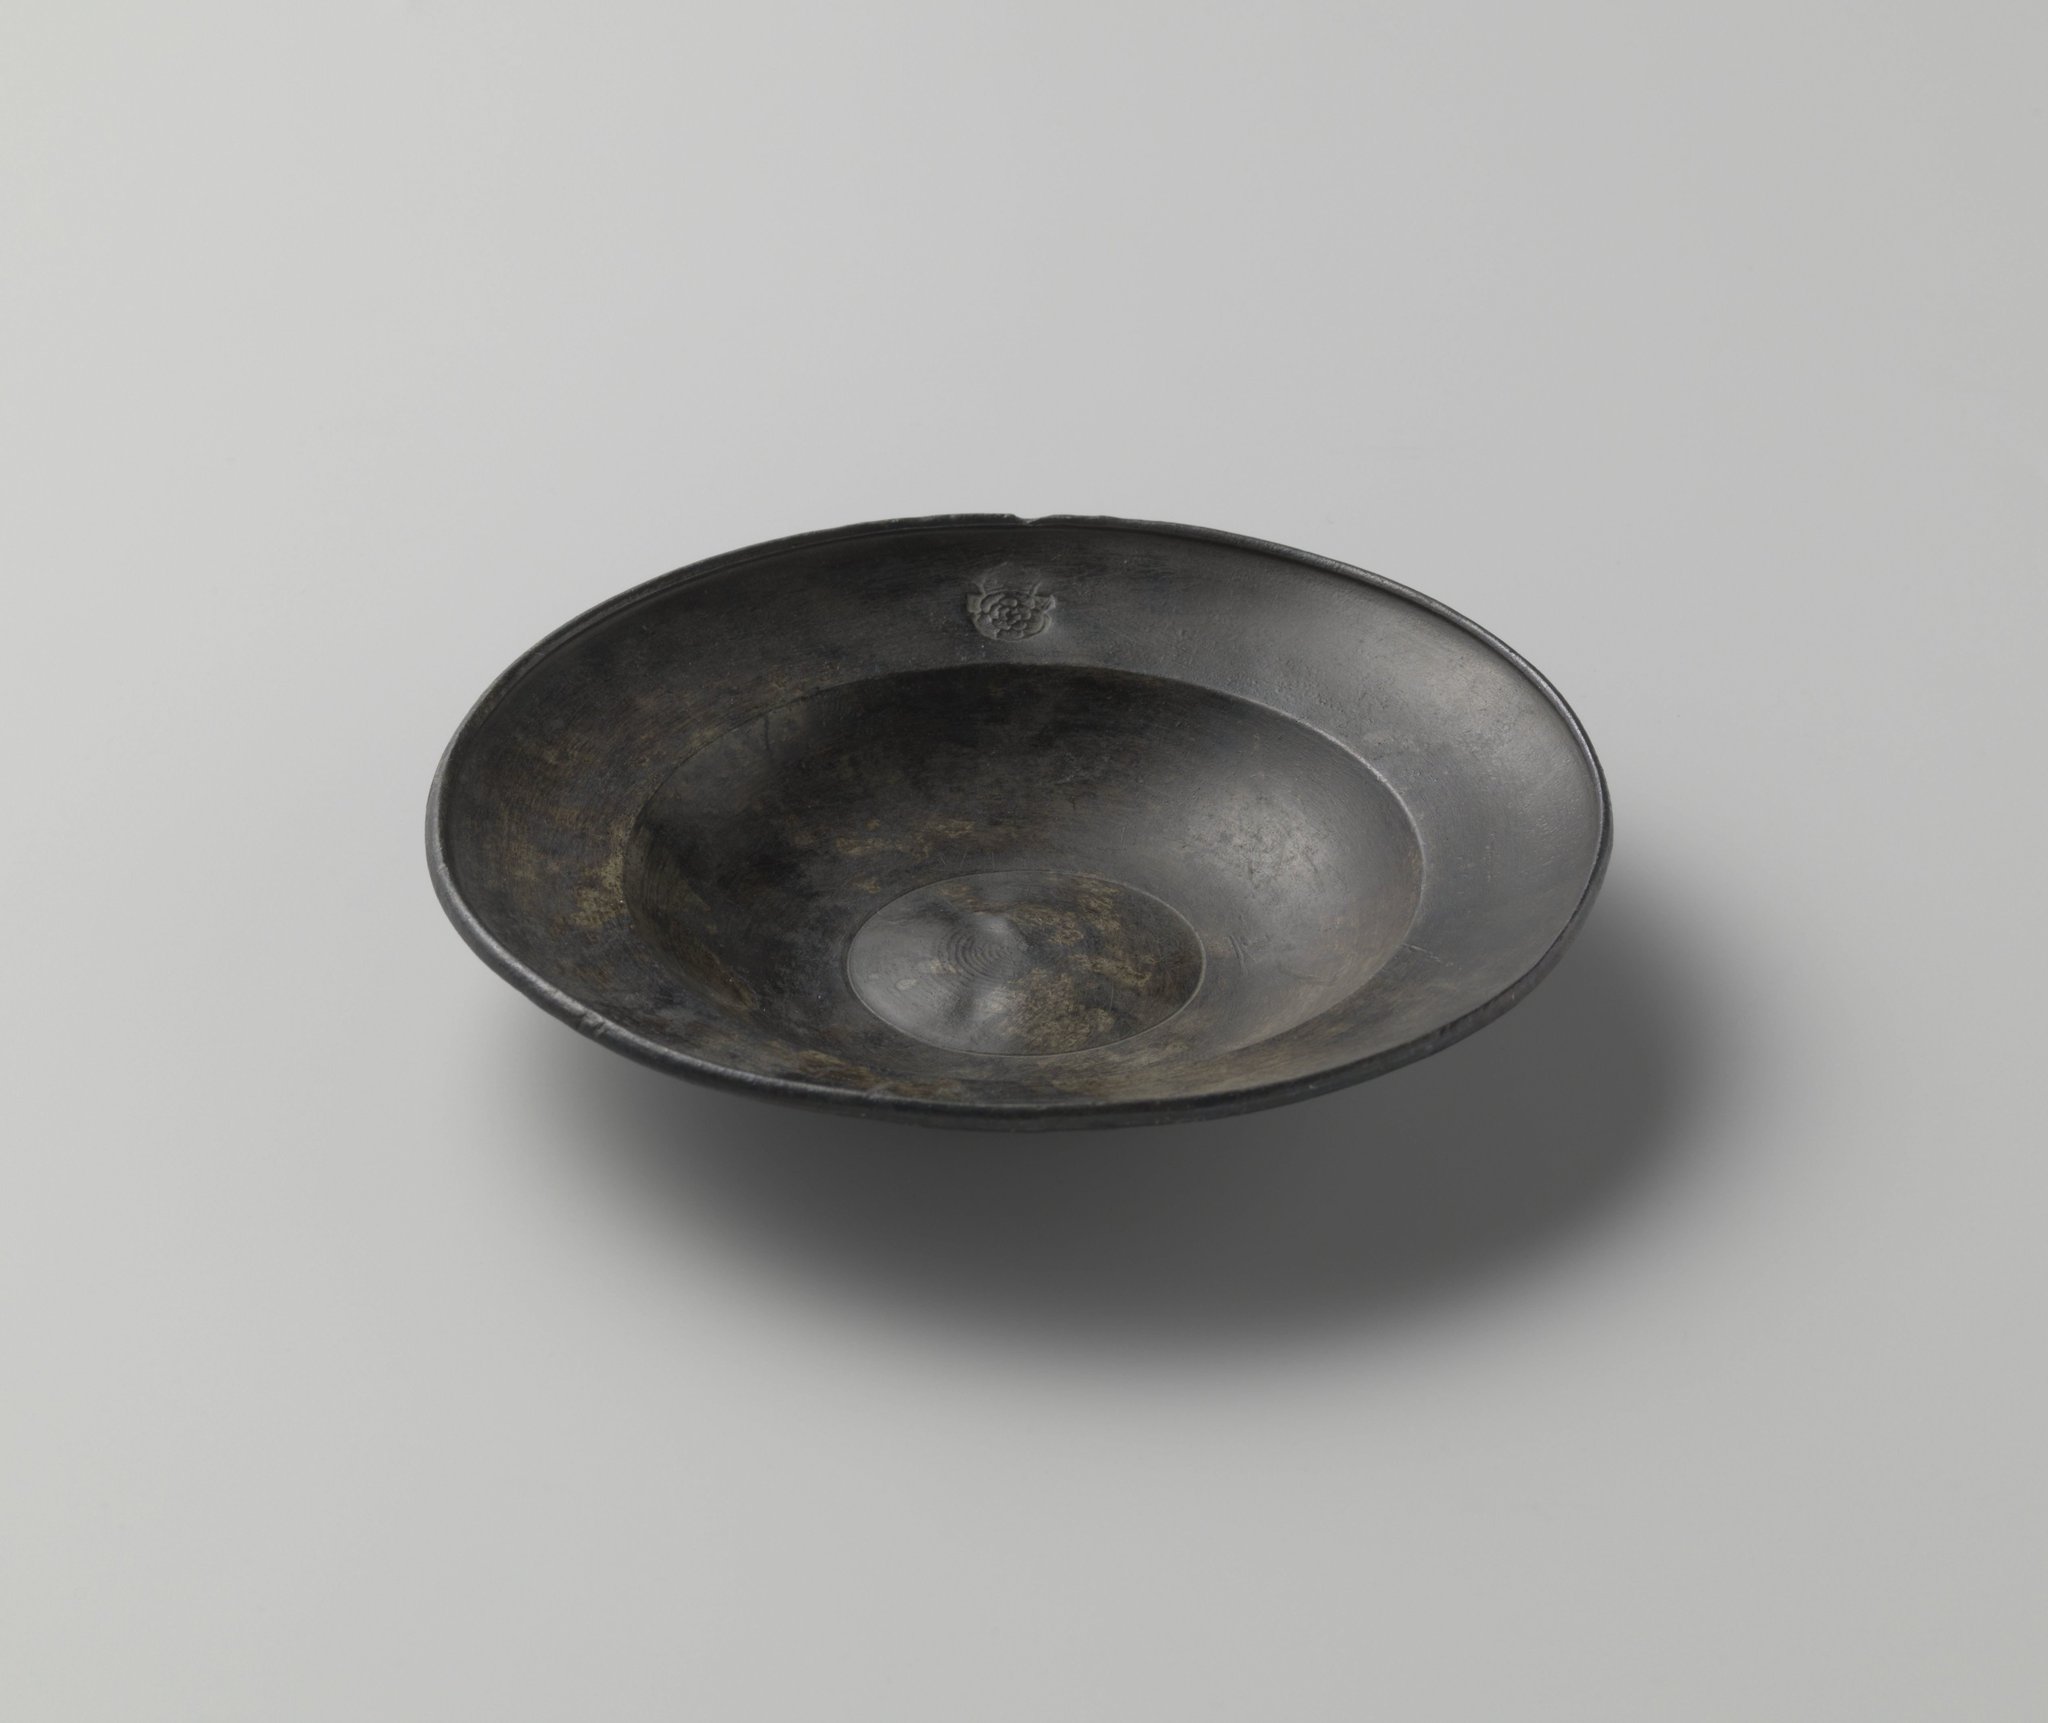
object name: platter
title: Schotel van tin met holle rand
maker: Anonymous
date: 1550-1600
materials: tin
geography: southern netherlands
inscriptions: quality mark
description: Plate. Pewter. Marked with a crowned rose and the initials I.W.. Netherlands, c. 1500.